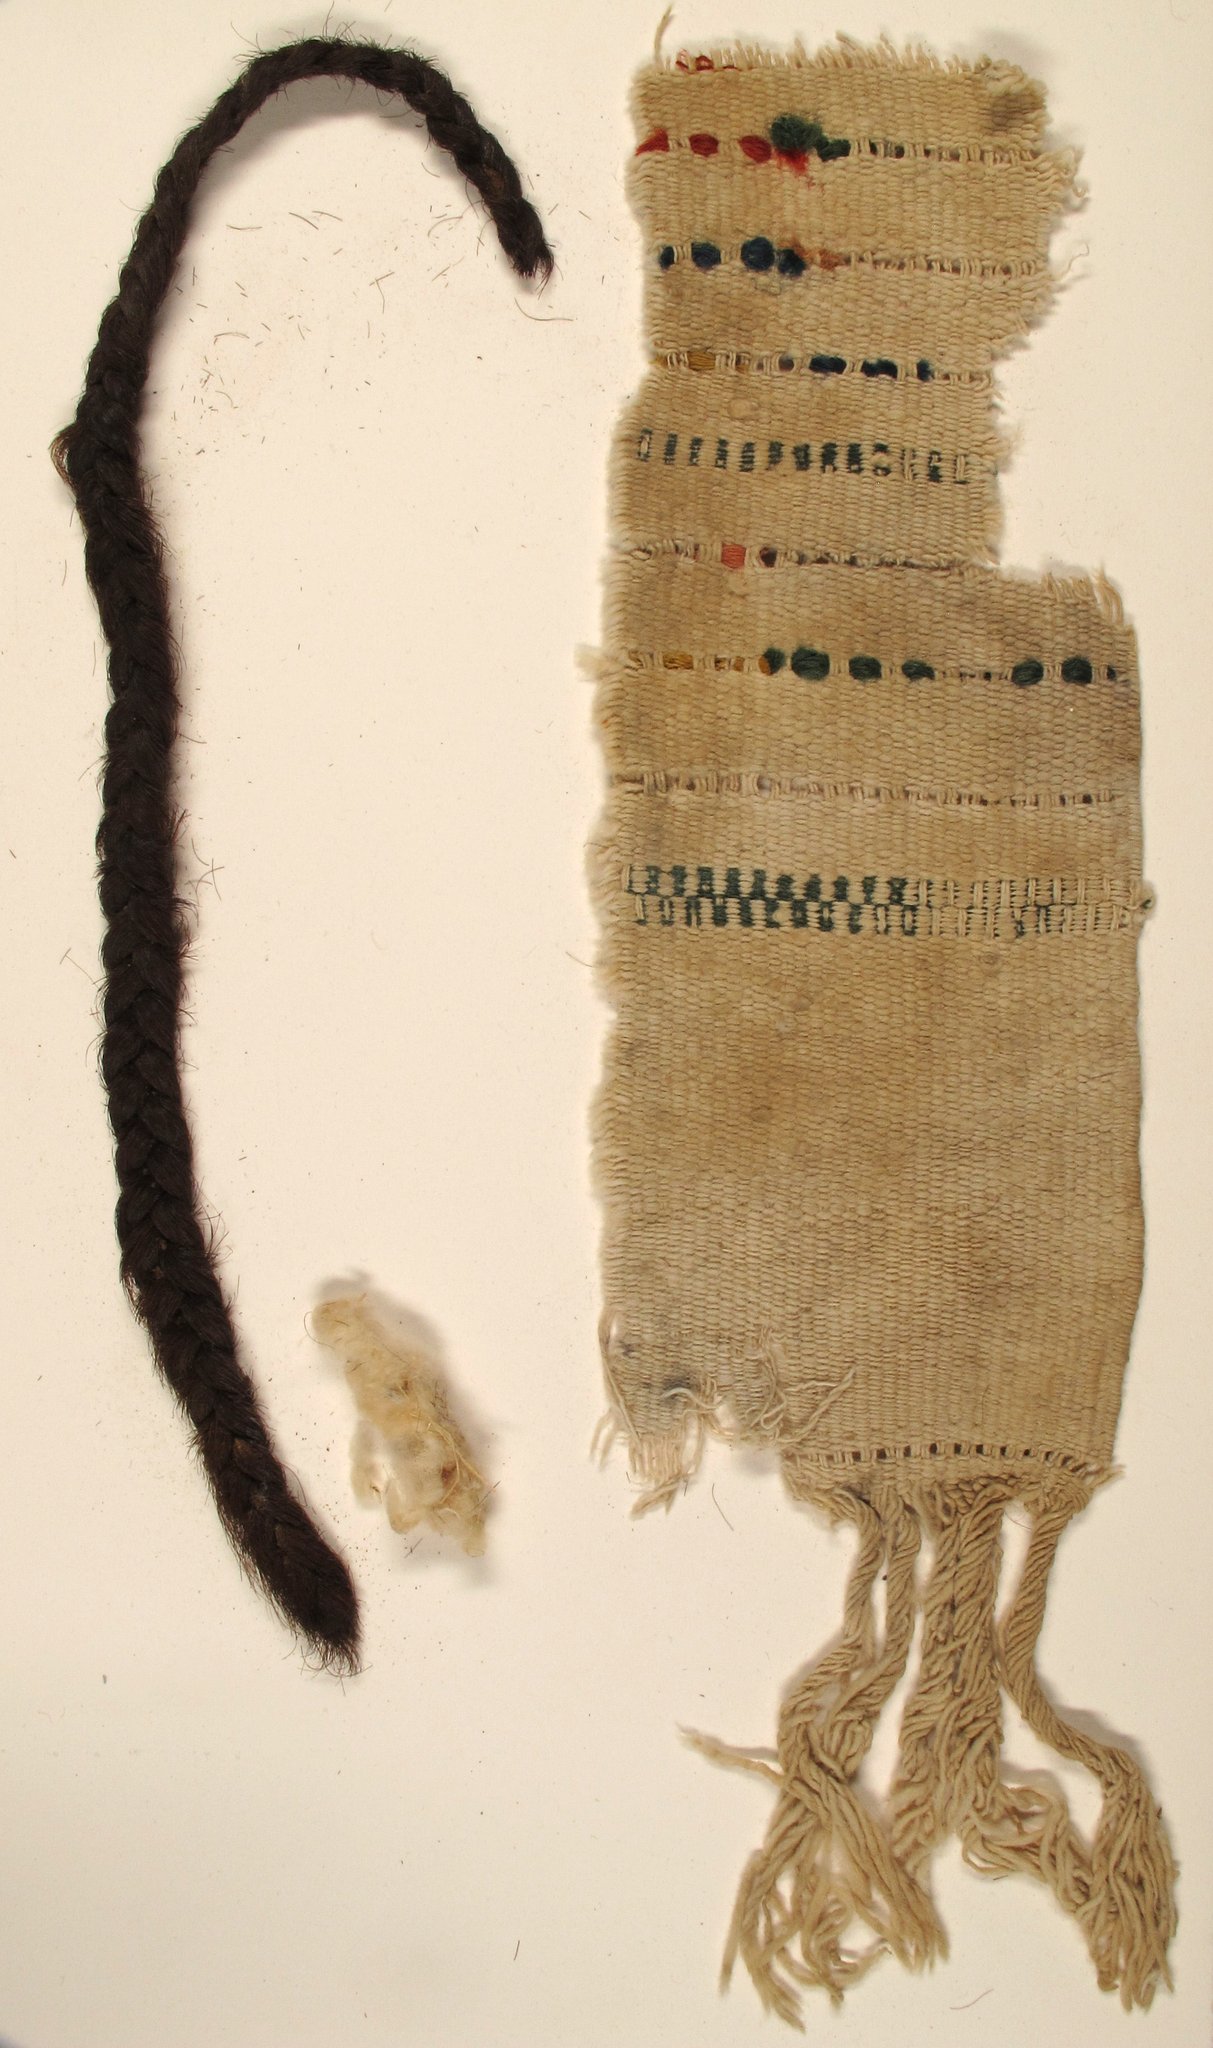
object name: fragment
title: Textile Fragments and braid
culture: coptic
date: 301-700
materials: cotton, hair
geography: egypt